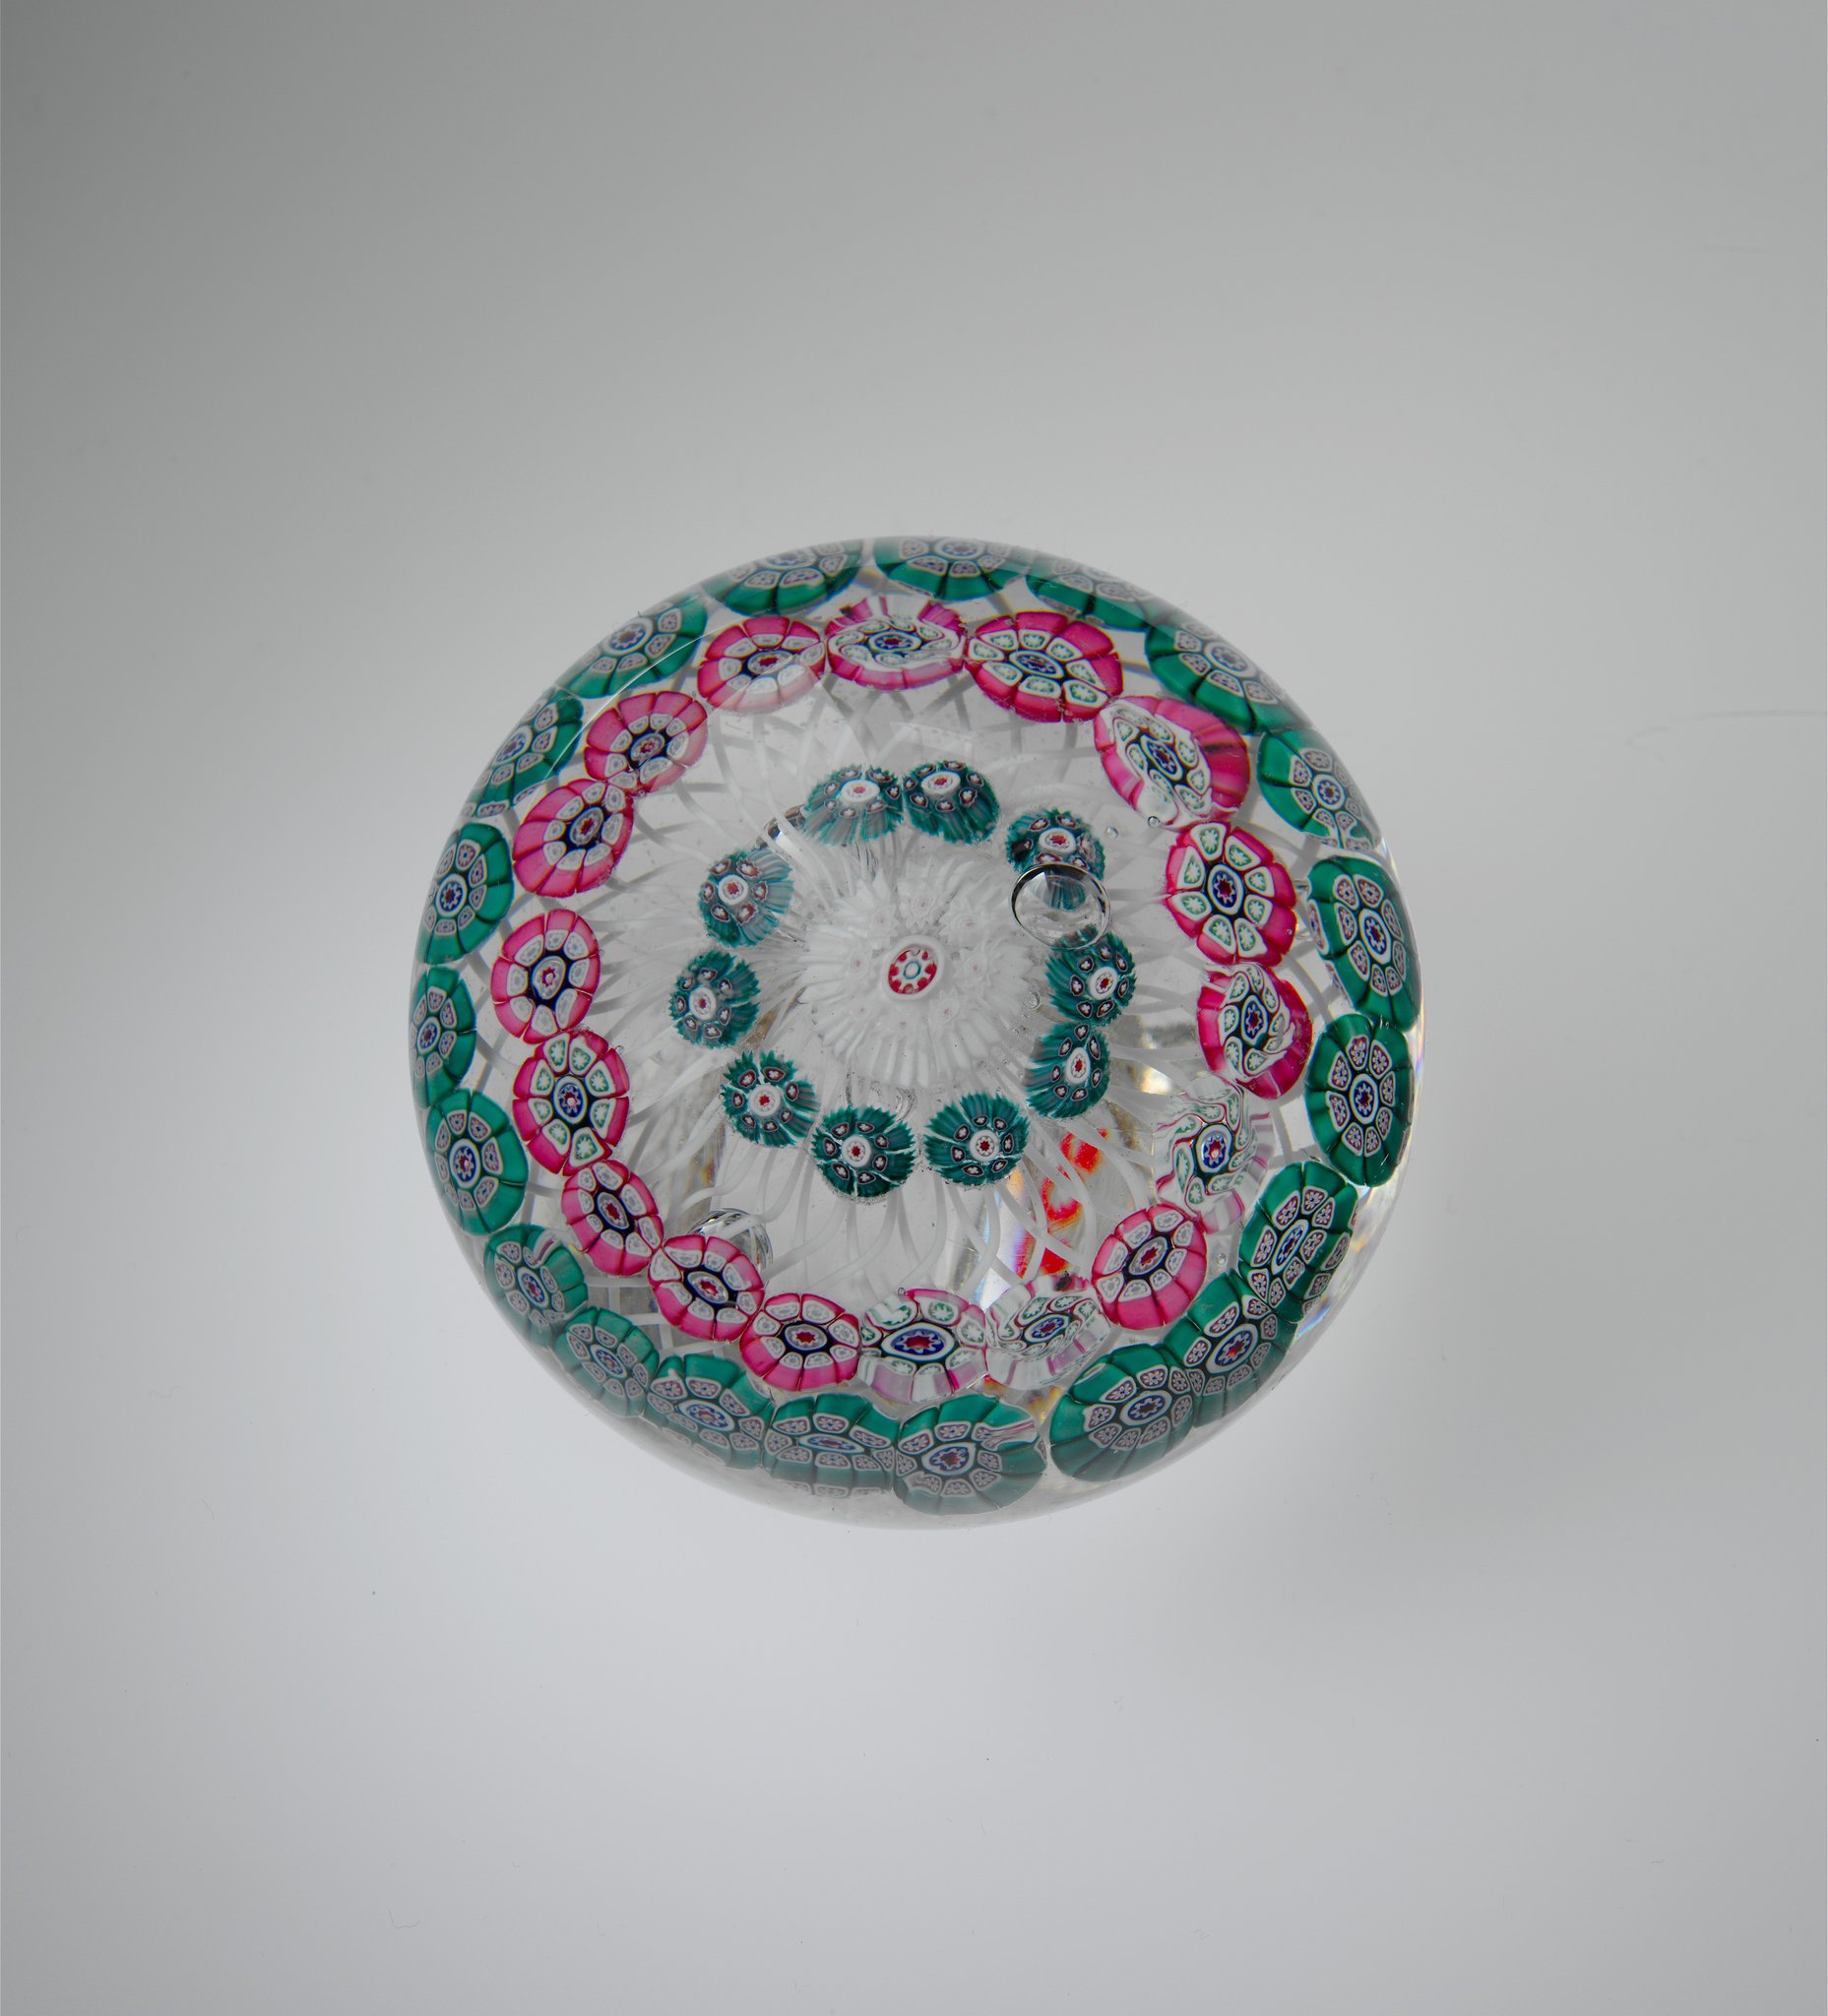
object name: paperweight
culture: american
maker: boston & sandwich glass company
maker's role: maker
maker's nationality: american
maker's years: 1825-1888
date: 1852-1880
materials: glass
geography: united states